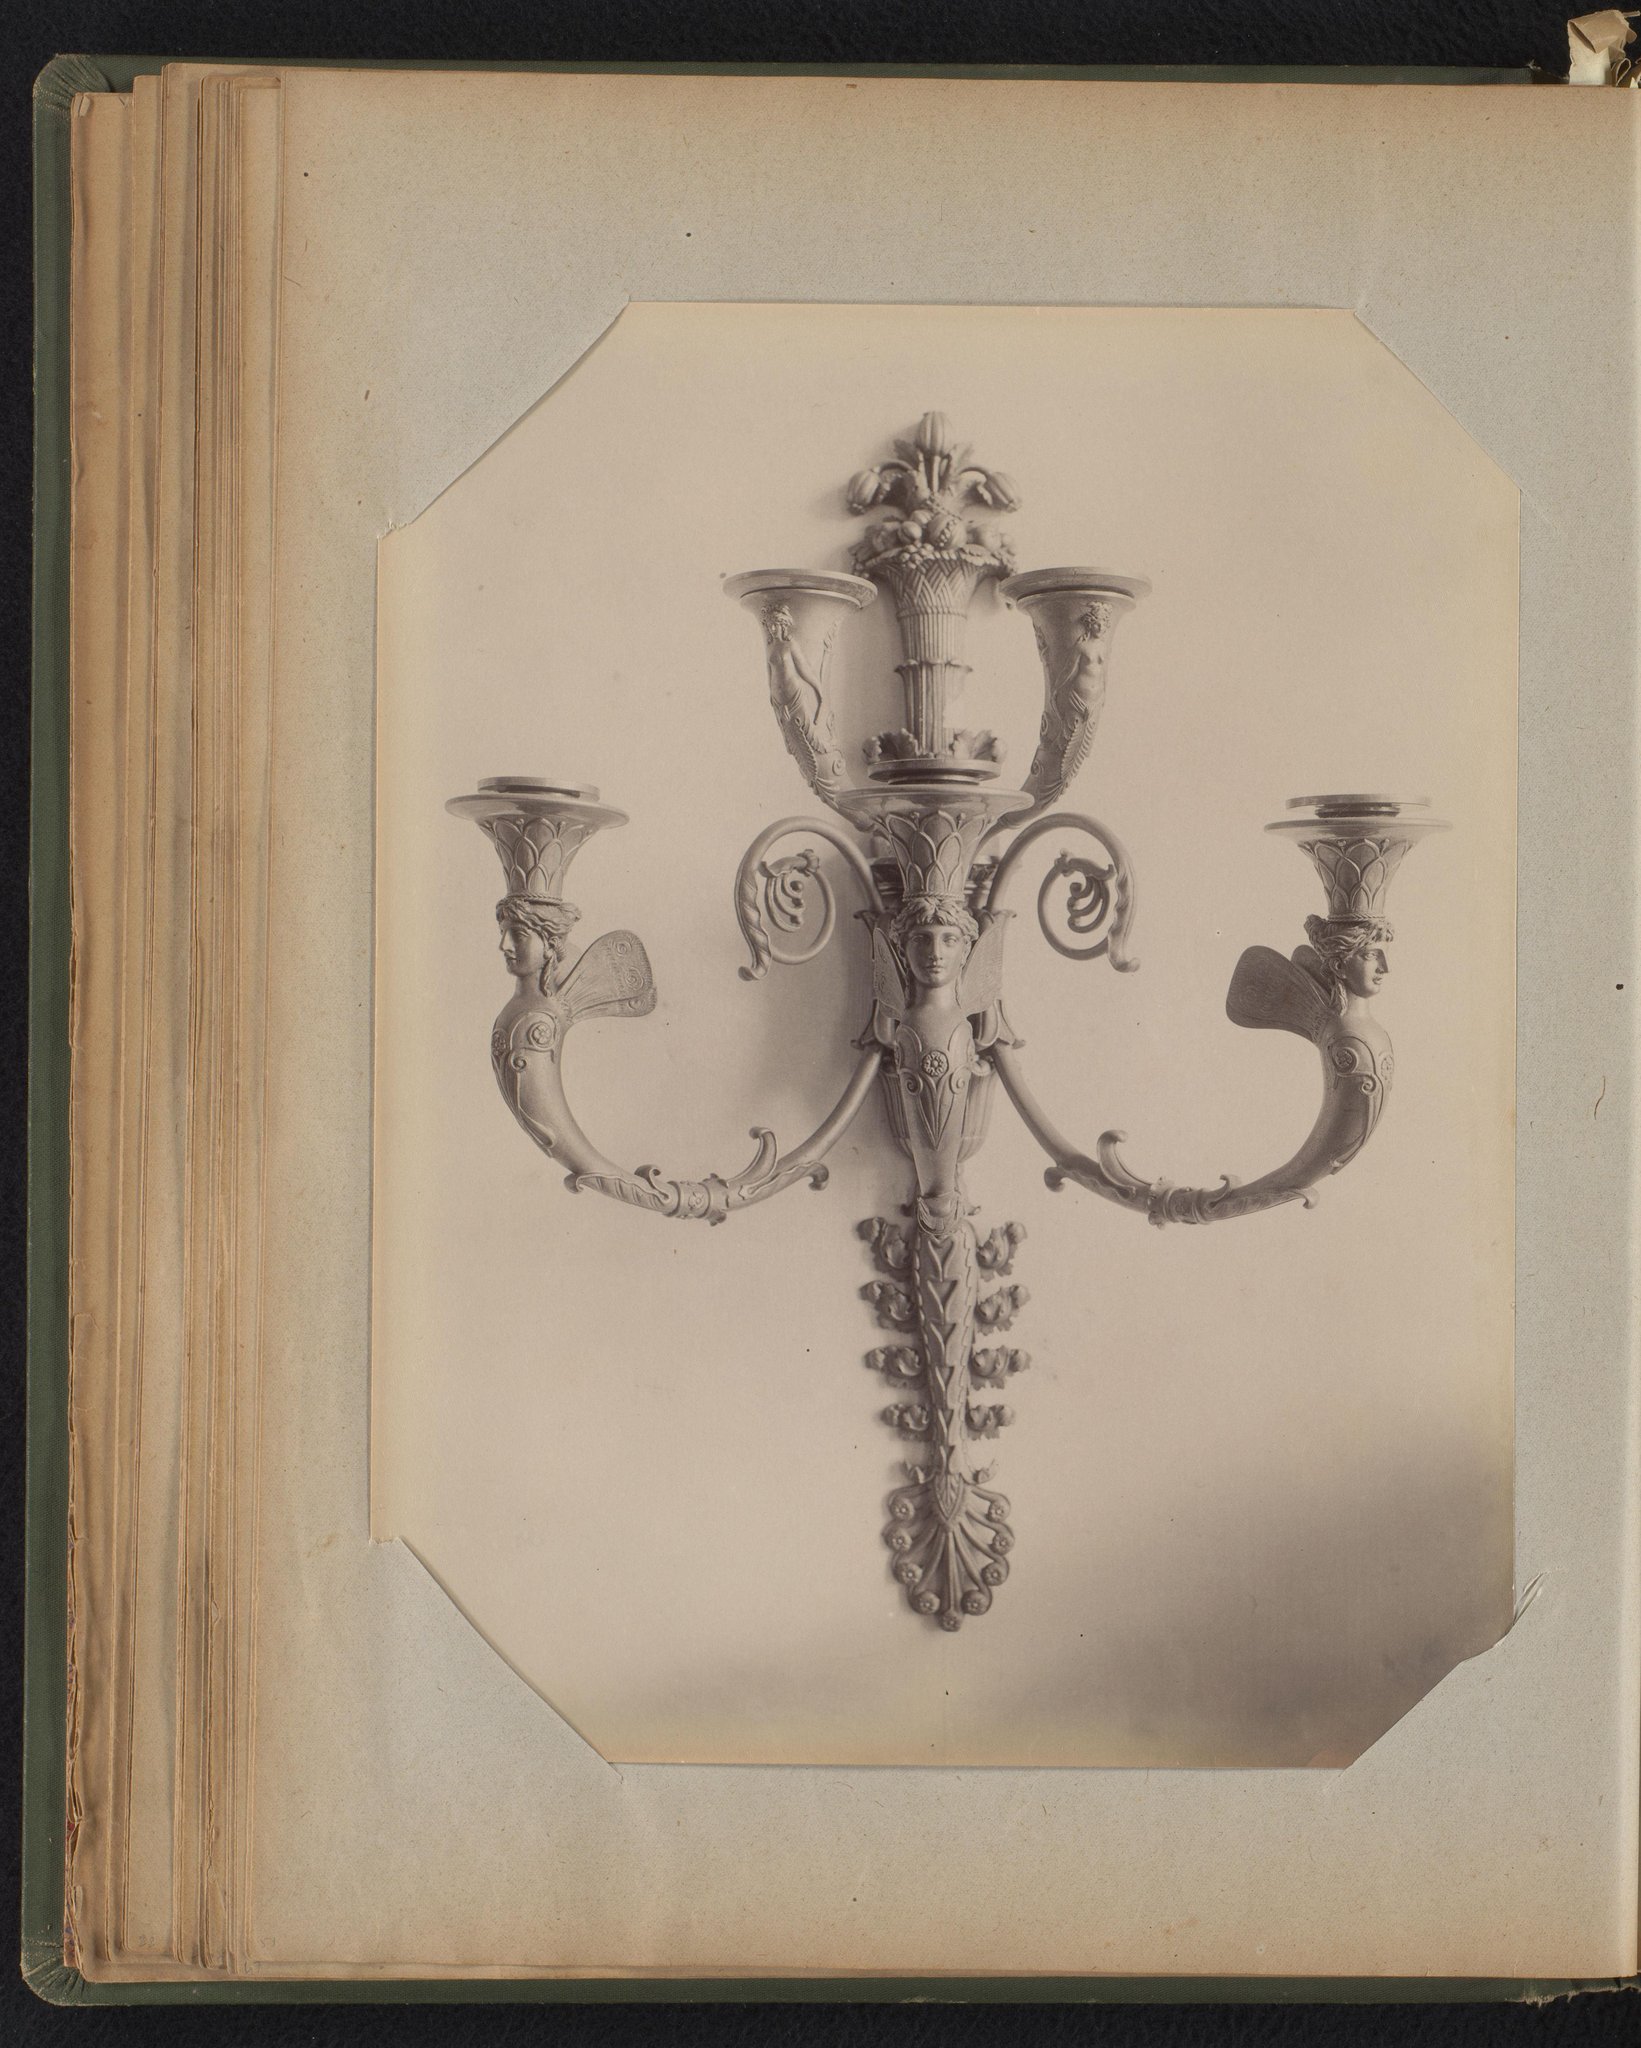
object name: photograph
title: Bronzen vijfarmige muurkandelaar gedecoreerd met bronzen mens figuren.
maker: Anonymous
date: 1860-1900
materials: paper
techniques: albumen print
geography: france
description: Onderdeel van een serie met betrekking tot het interieur van het paleis van Versailles met kroonluchters, deuren, portalen en meubelstukken.